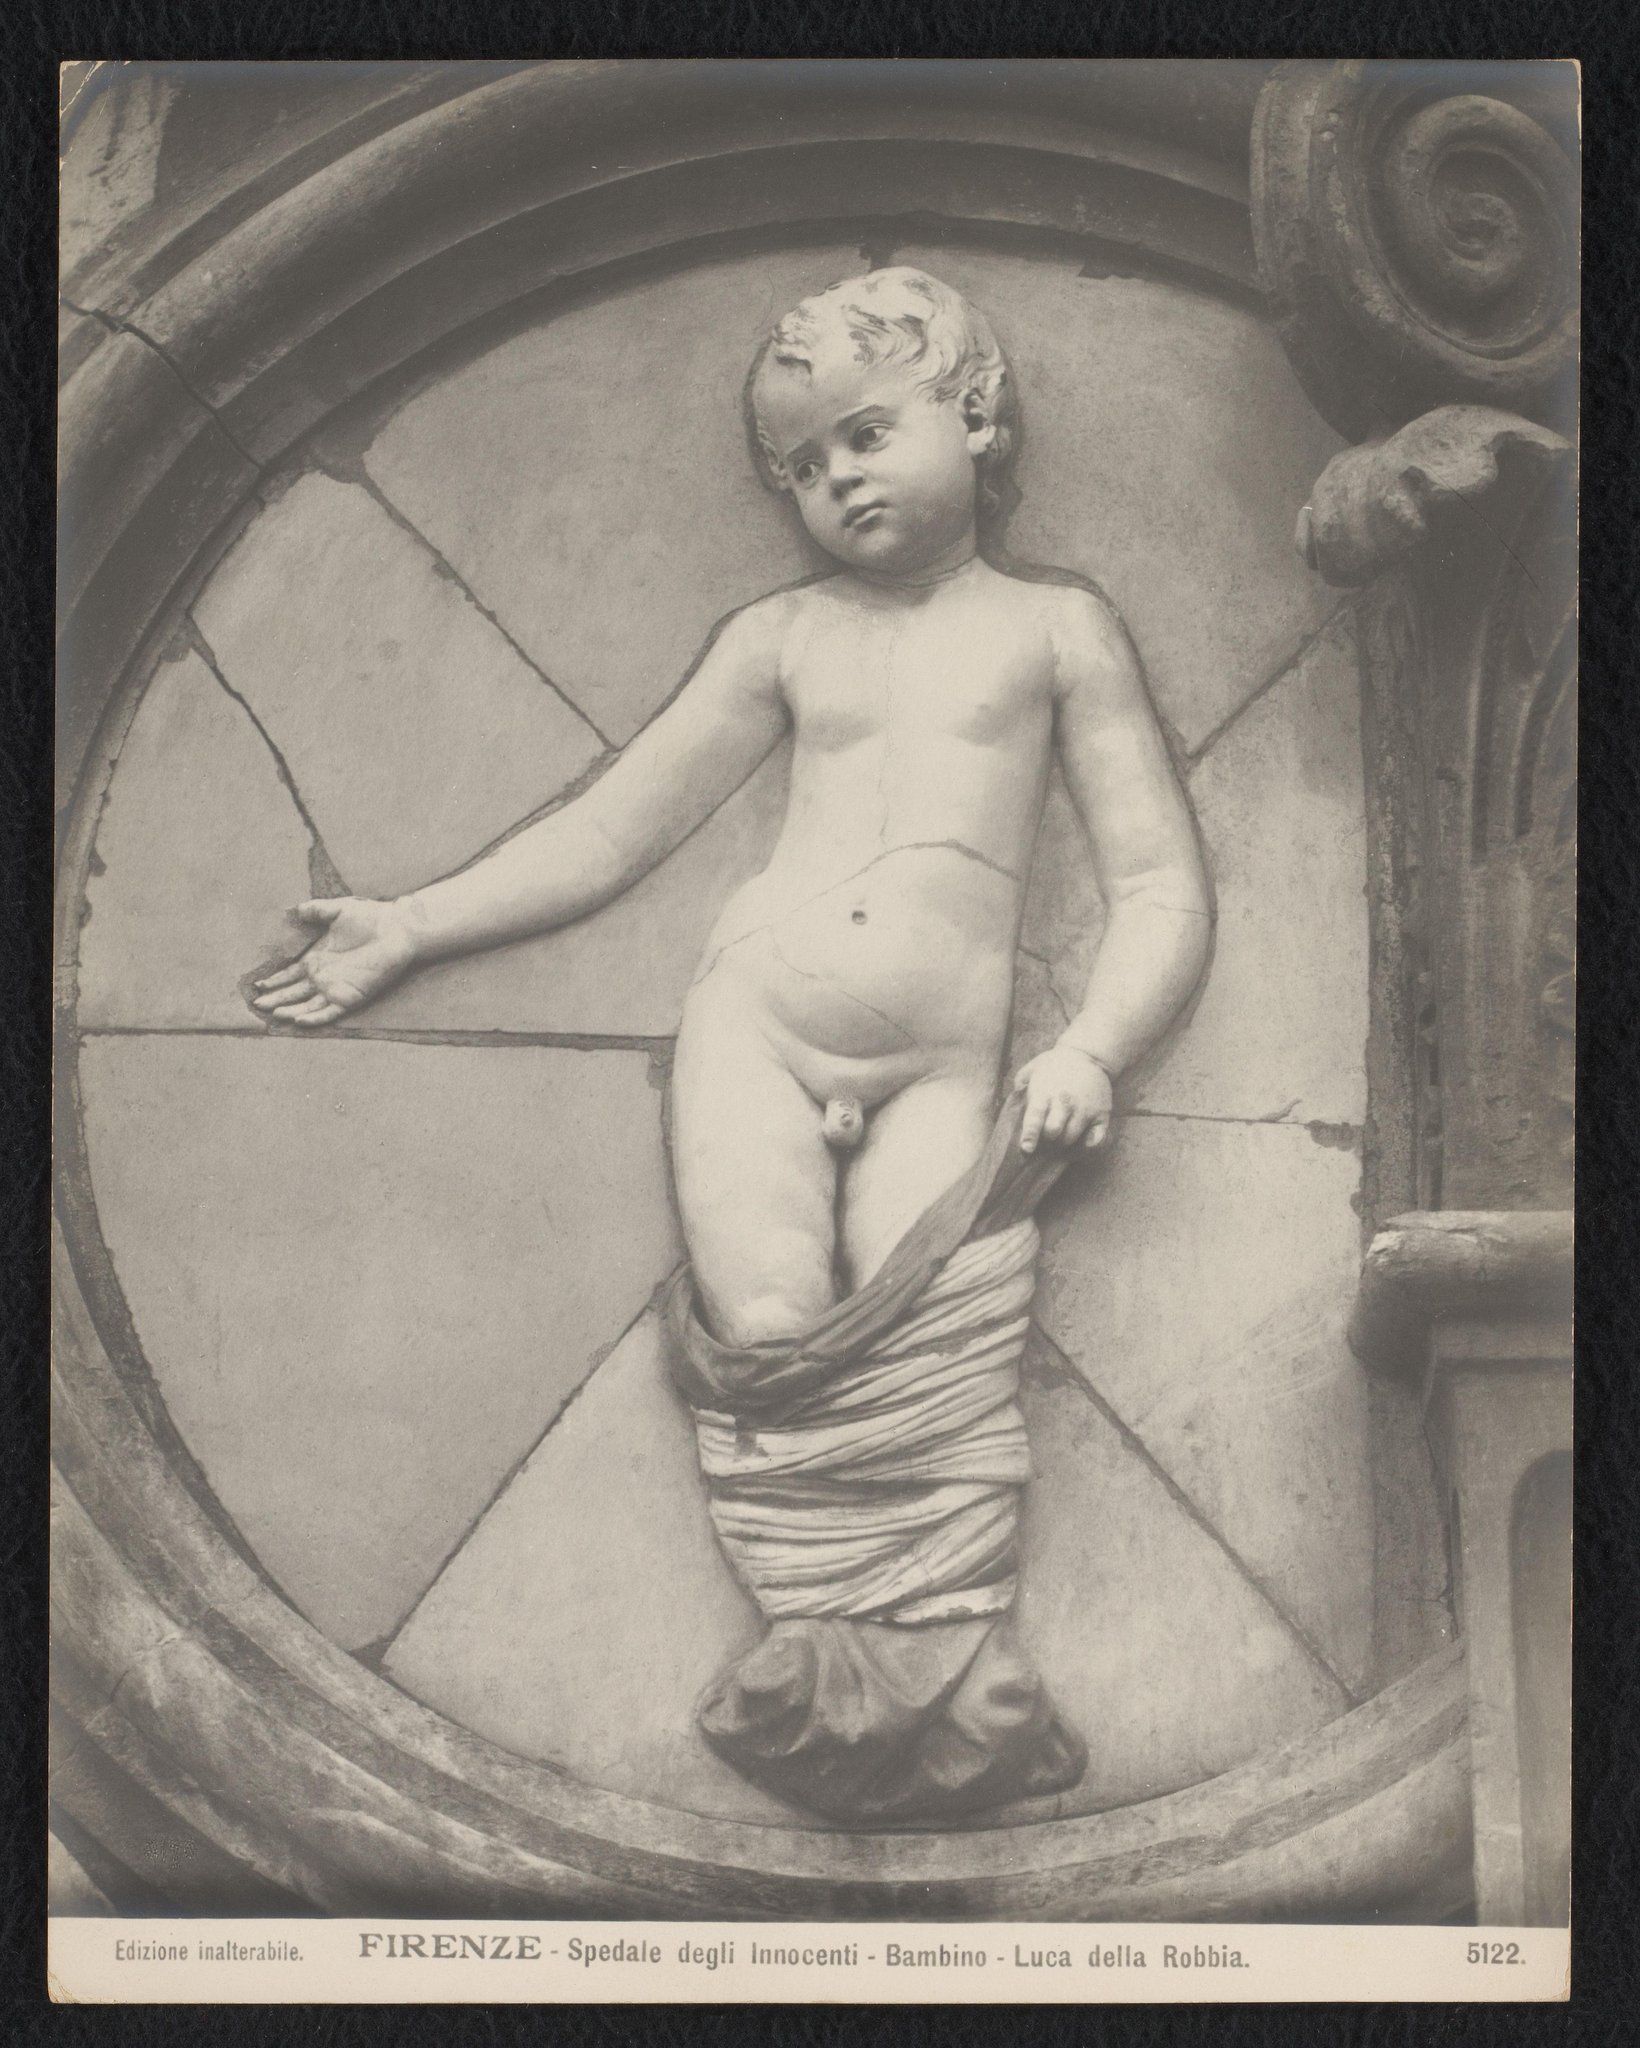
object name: photograph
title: Tondo met baby door Andrea della Robbia aan het Ospedale degli Innocenti te Florence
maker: Anonymous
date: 1900-1920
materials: paper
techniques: gelatin silver print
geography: florence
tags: art (+ relief ~ sculpture)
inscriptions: collector's mark: ‘RIJKS SCHOOL VOOR KUNSTNIJVERHEID/ GROEP’, number: ‘5122.’, inscription: ‘Edizione inalterabile.’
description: Deze foto maakt deel uit van een omslag.